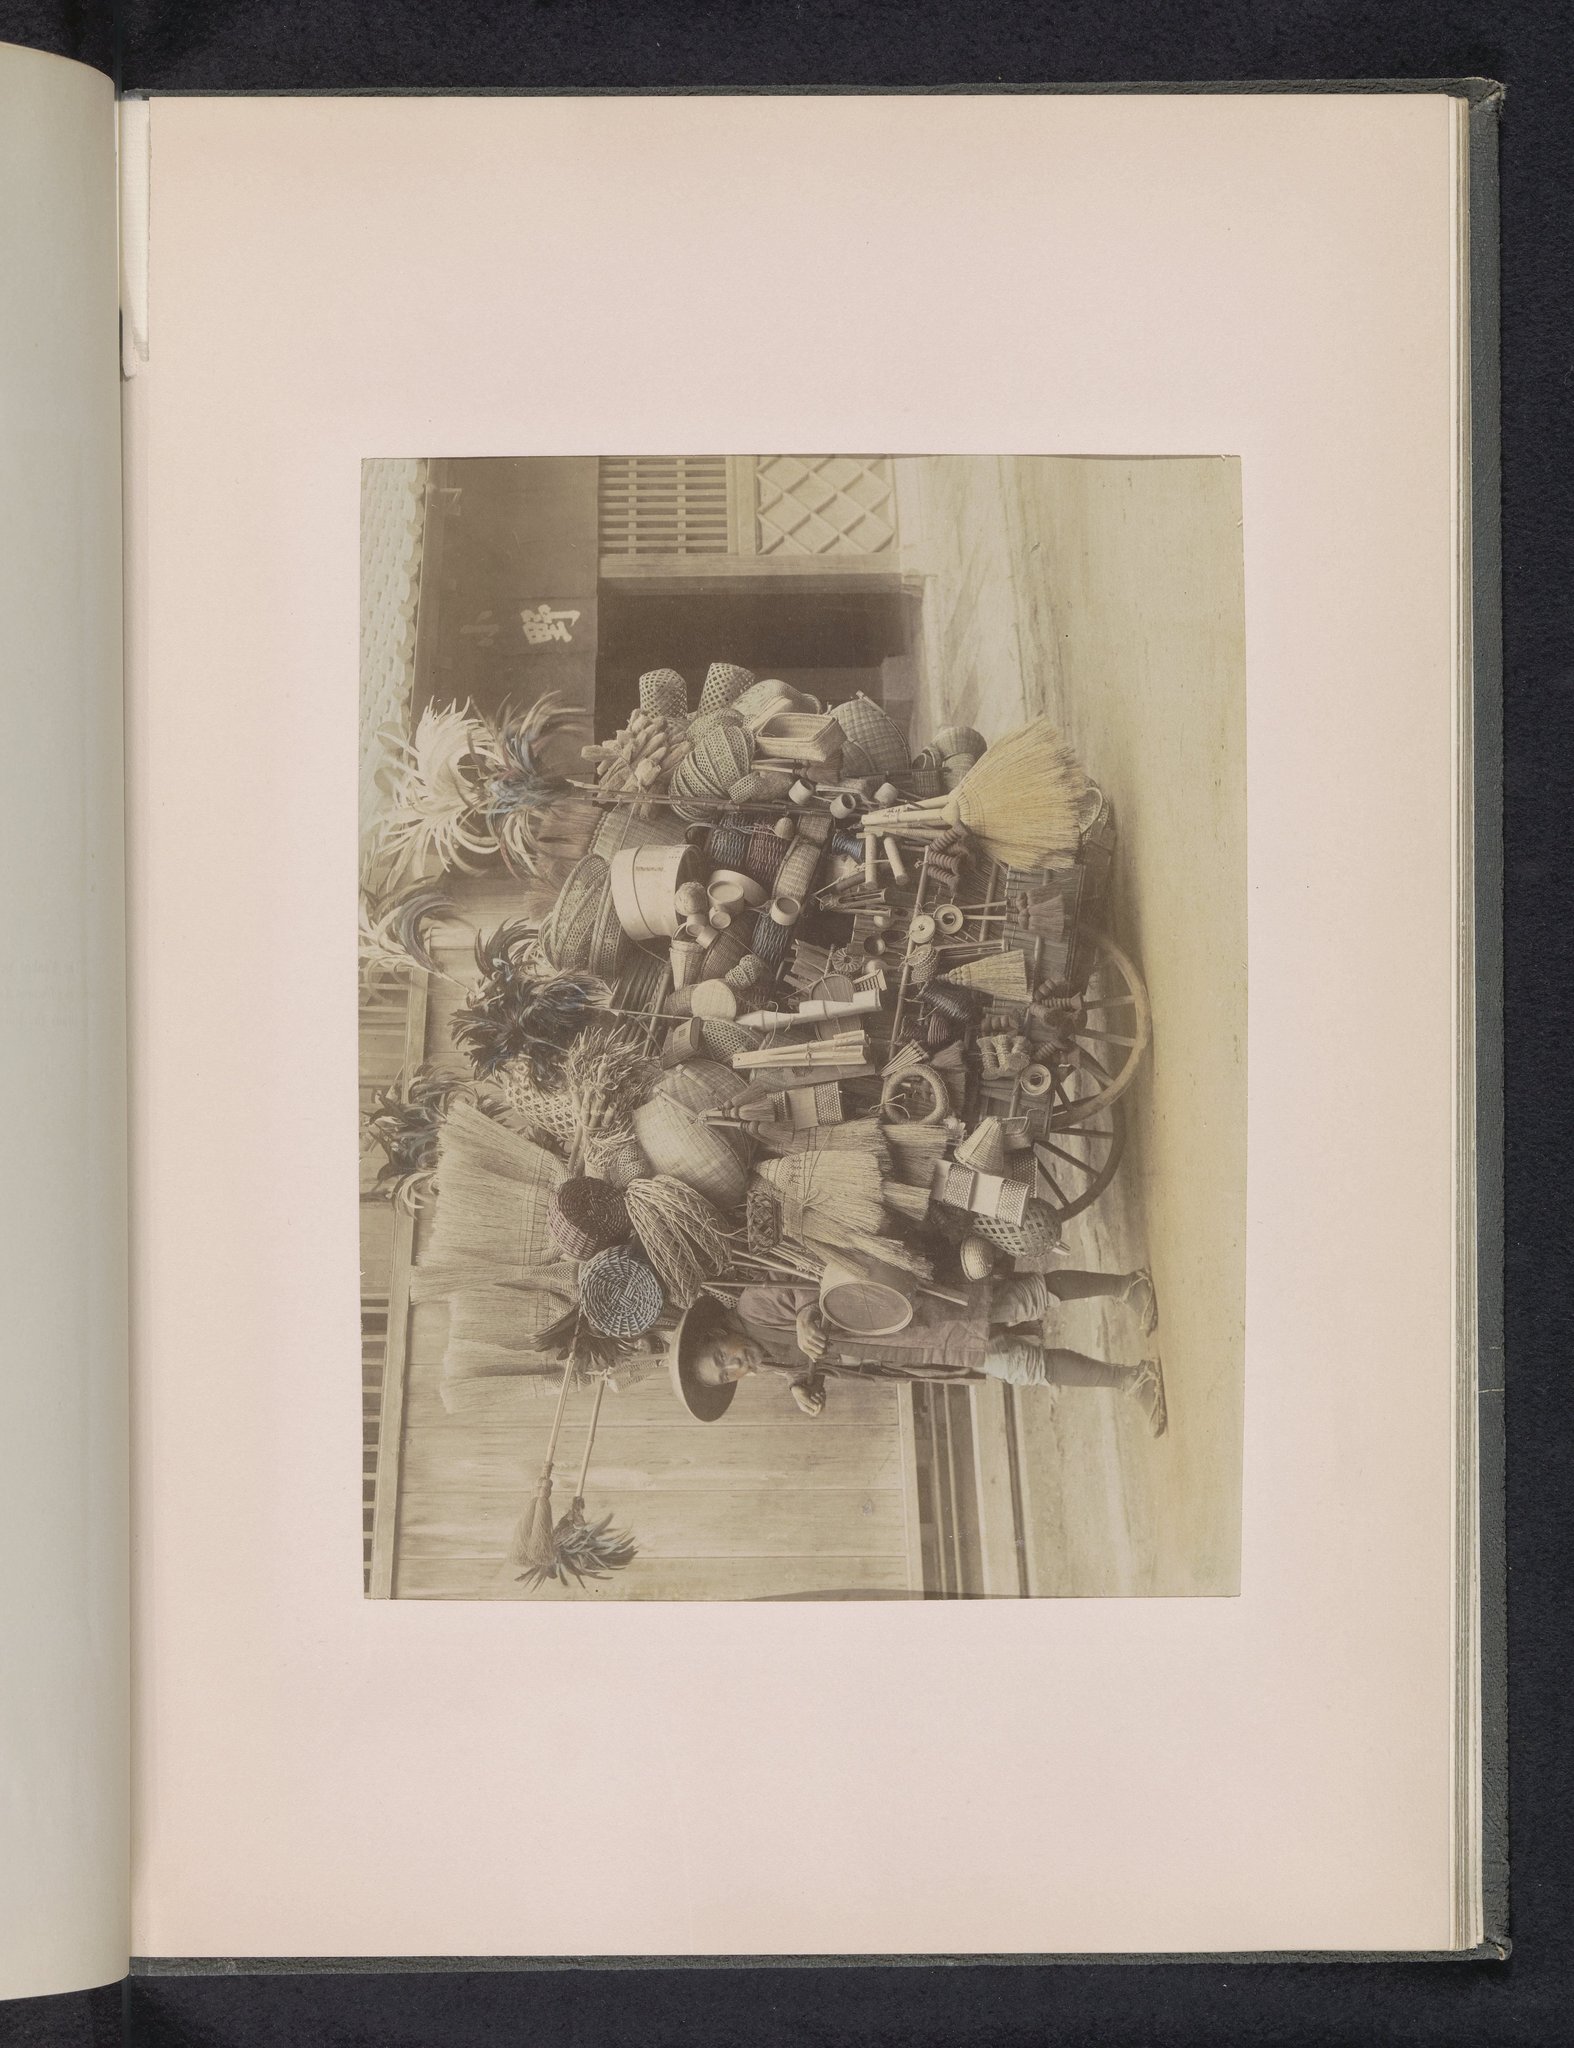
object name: page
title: Rondreizende koopman met een handkar en koopwaar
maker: Anonymous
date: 1887-1897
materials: photographic support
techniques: albumen print, hand coloring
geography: japan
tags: hand-cart, merchant, salesman